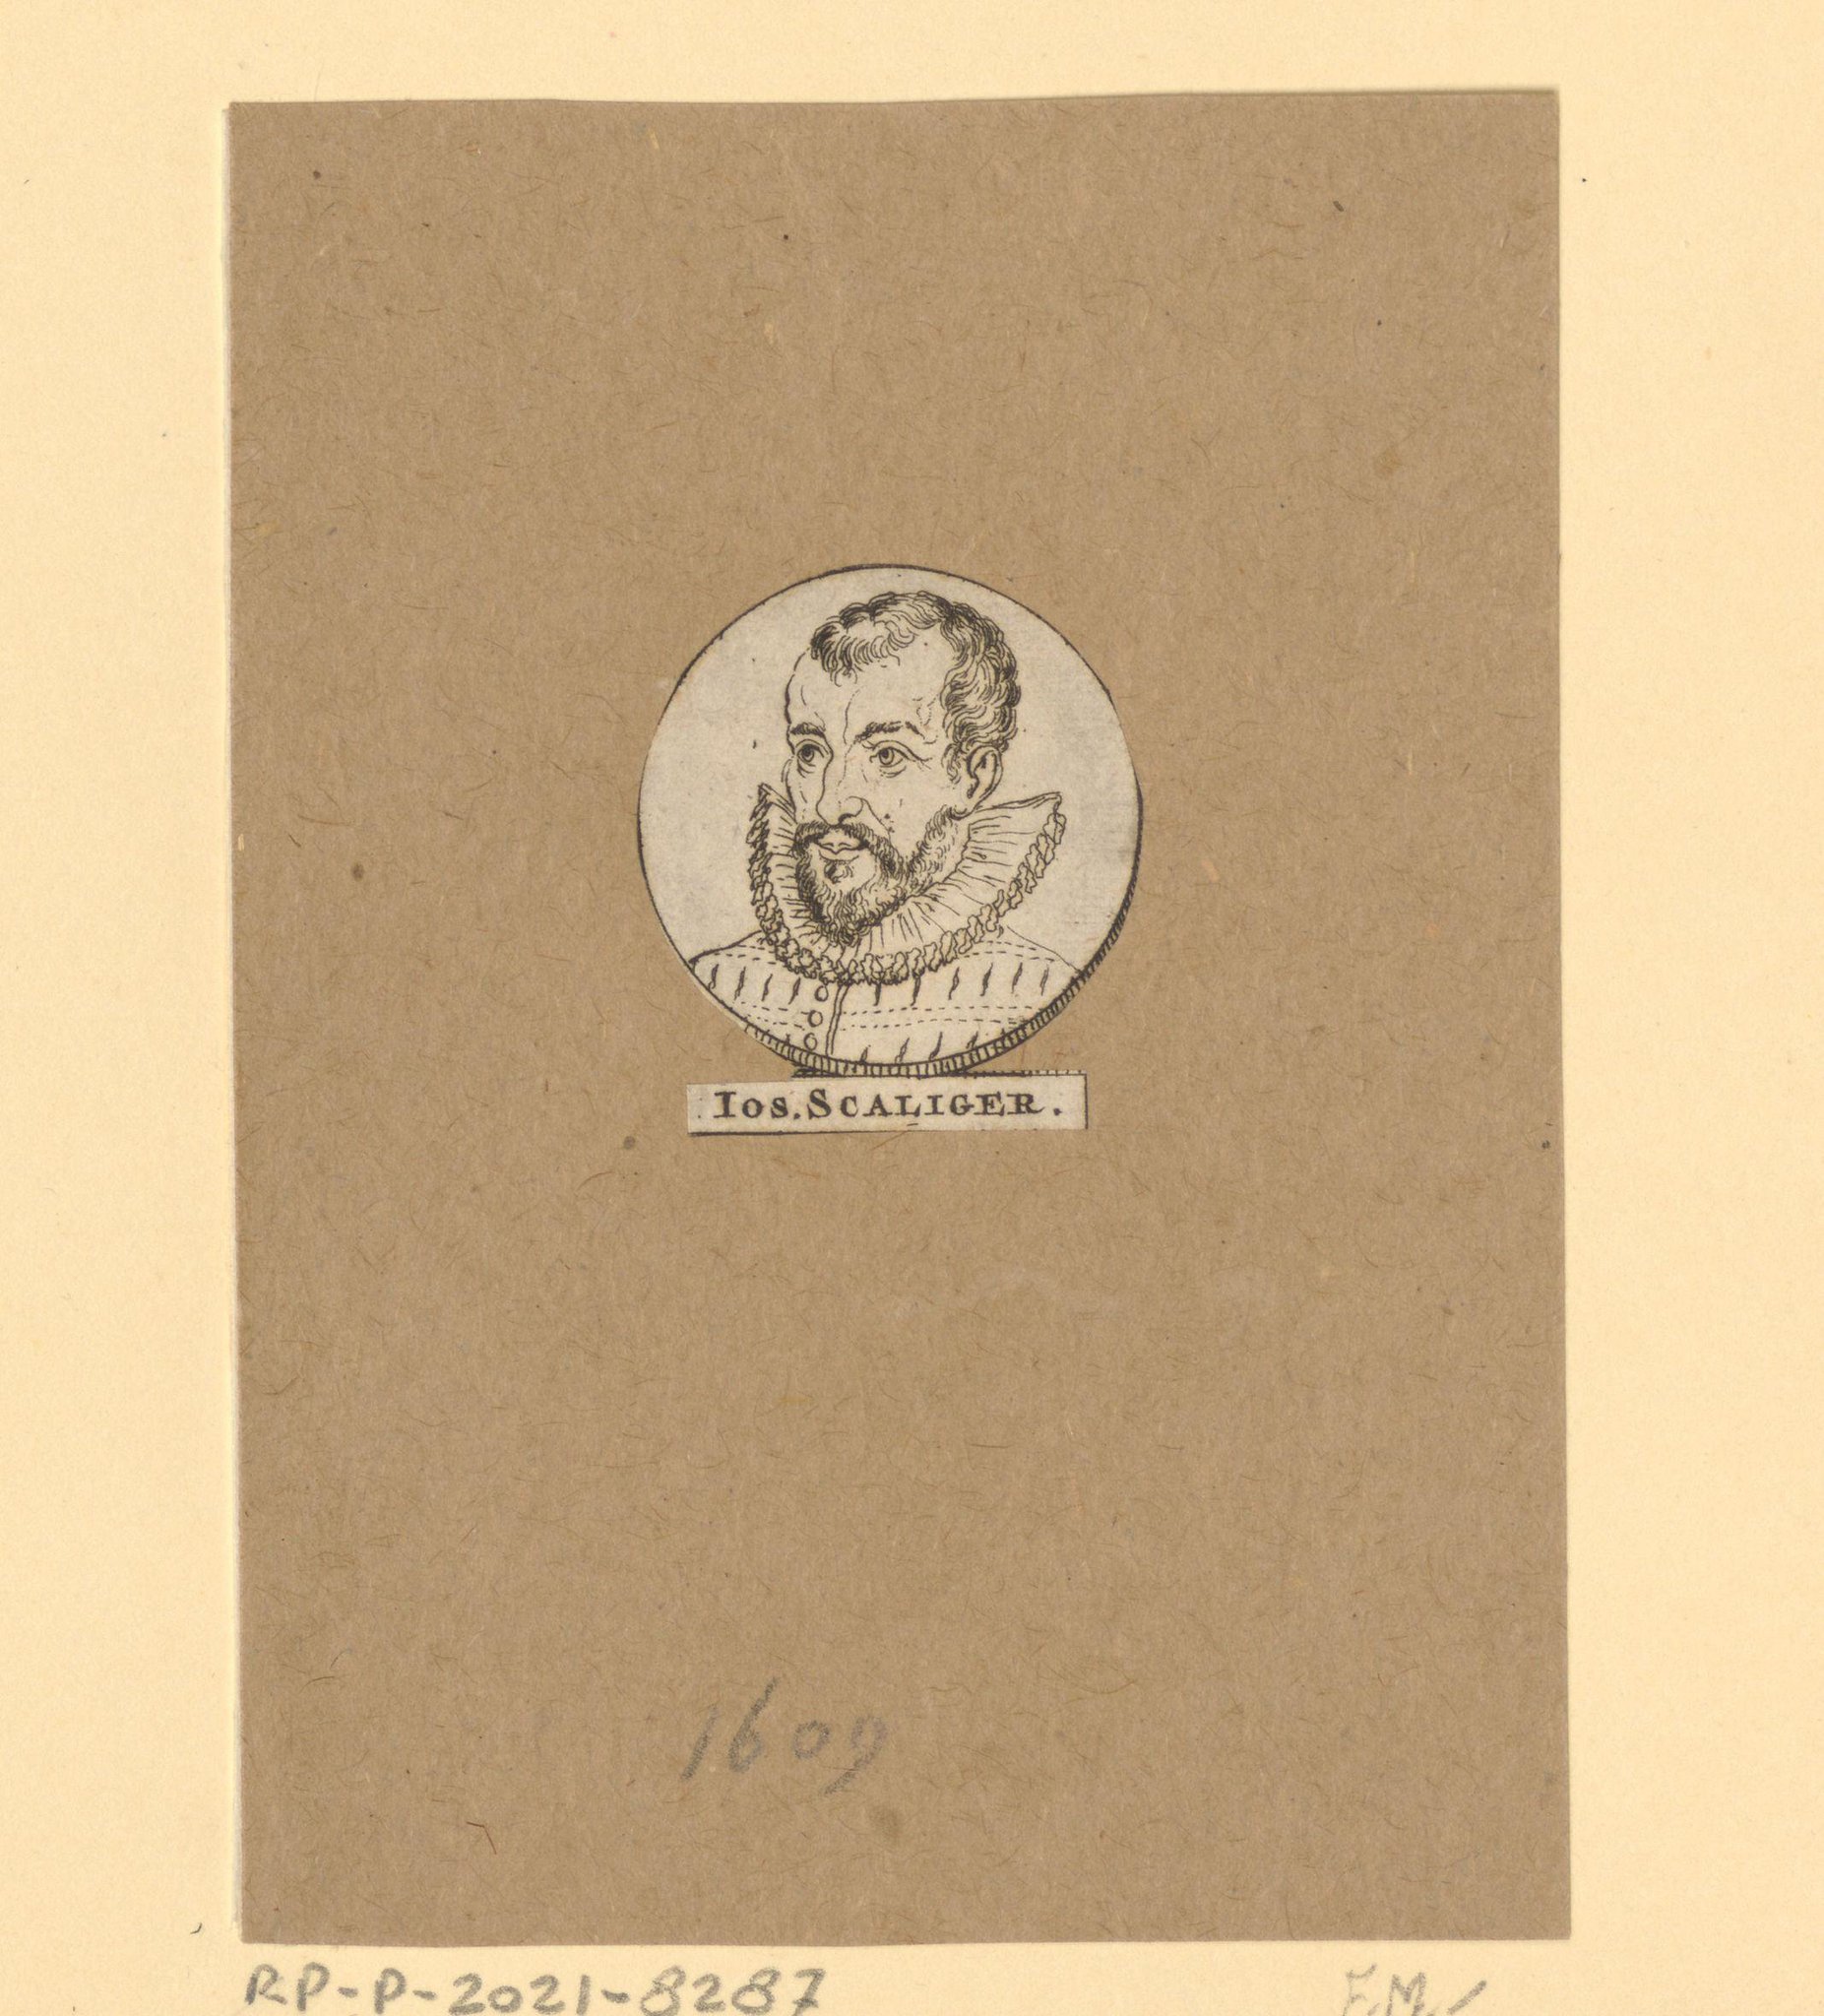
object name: print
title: Portret van Josephus Scaliger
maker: Anonymous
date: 1600-1750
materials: paper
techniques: etching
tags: historical persons, professor